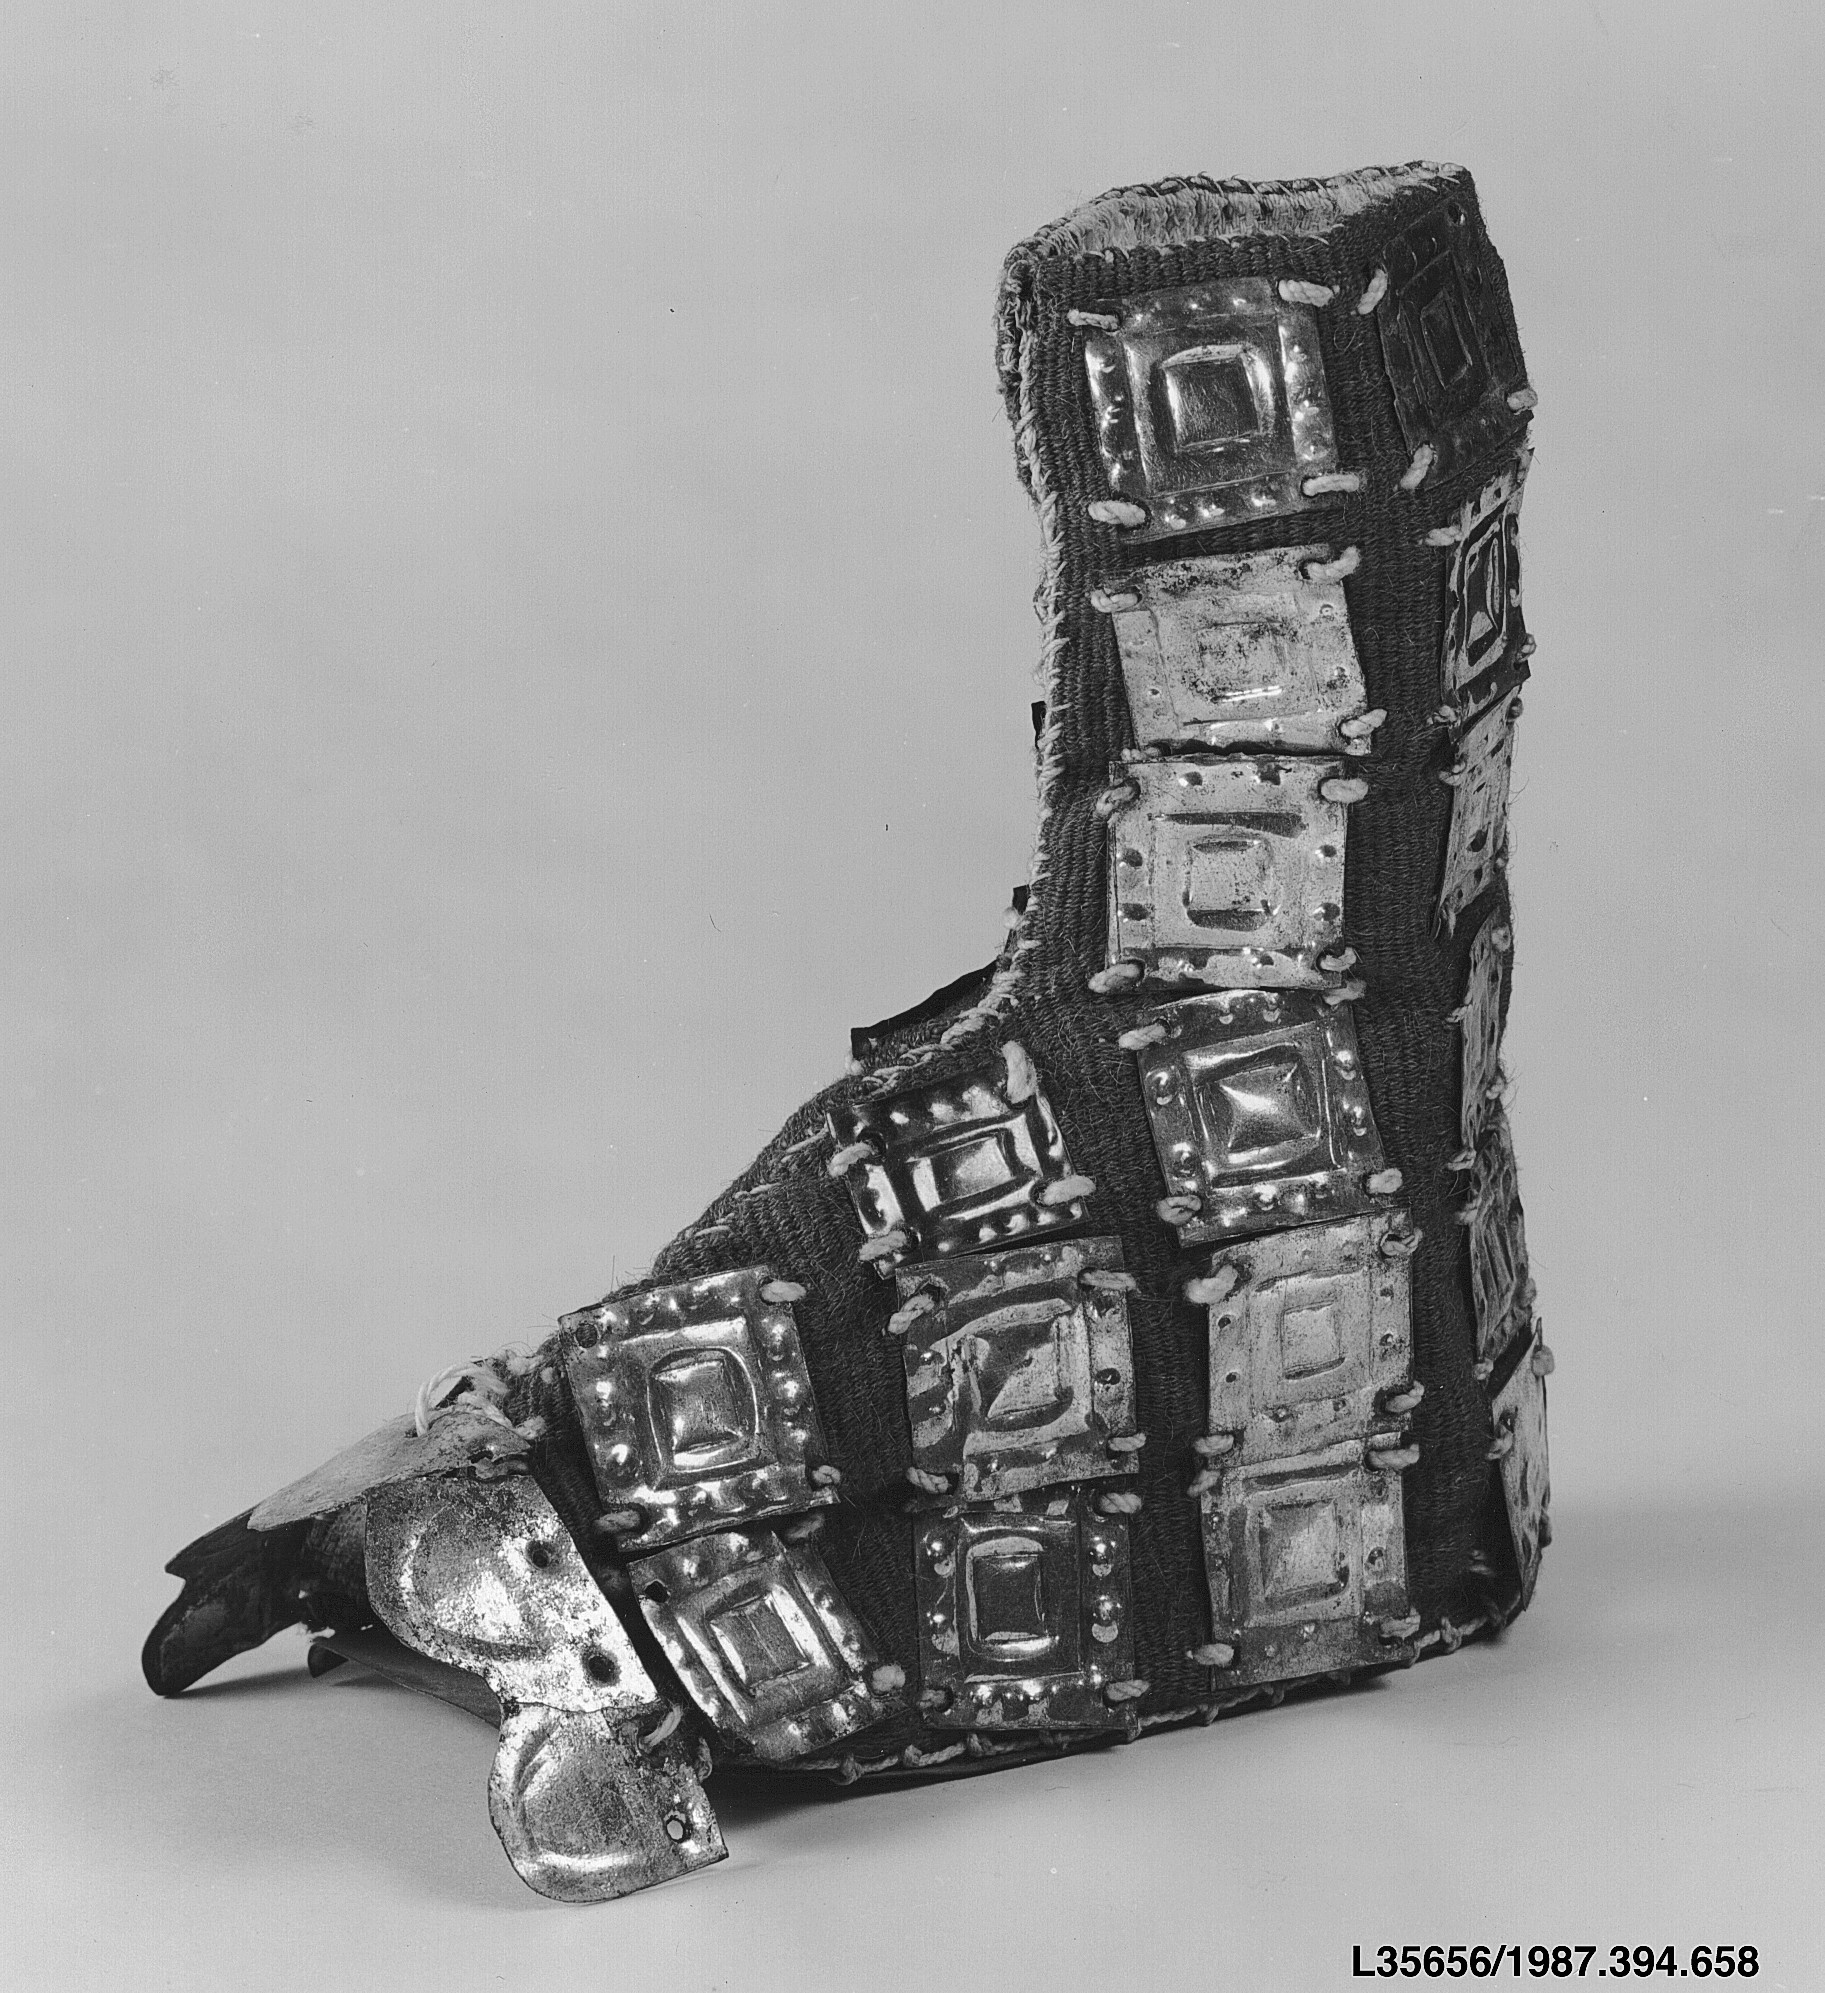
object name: boot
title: Slipper with Metal Ornaments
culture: chancay or chimú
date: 1201-1500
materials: animal fiber, cotton, metal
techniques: hammering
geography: peru